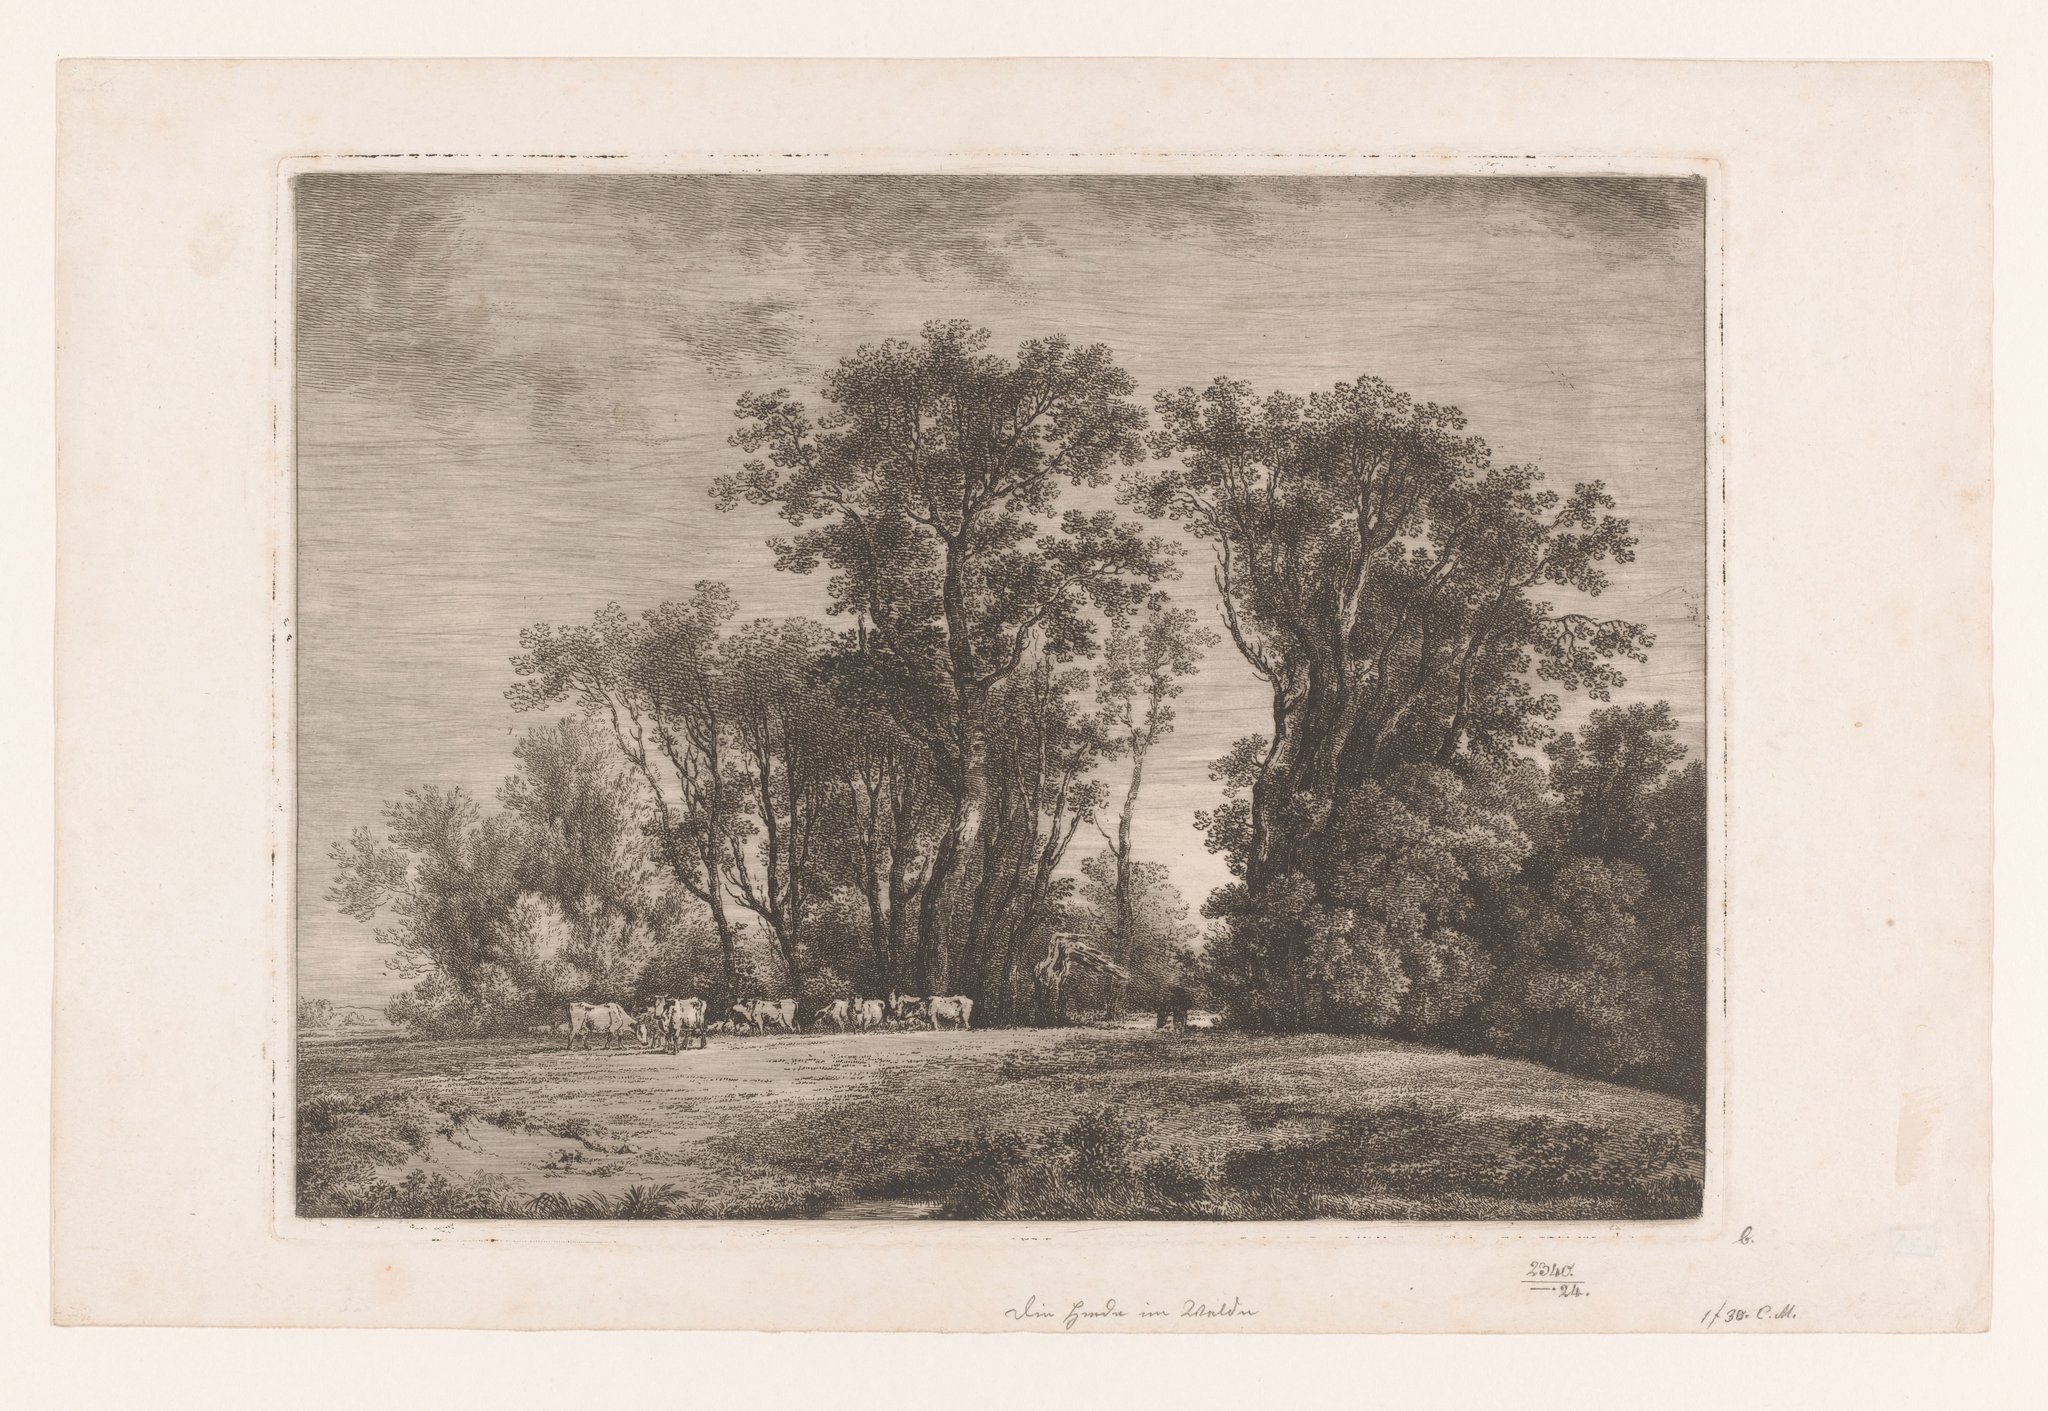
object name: print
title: Koeien bij een bosrand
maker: martin von molitor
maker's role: painter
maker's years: 1759-1812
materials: paper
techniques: aquatint, etching, intaglio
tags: cow, fringe, edge of the wood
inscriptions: collector's mark: Lugt 2228, collector's mark: Lugt 3976, collector's mark: Lugt 2233